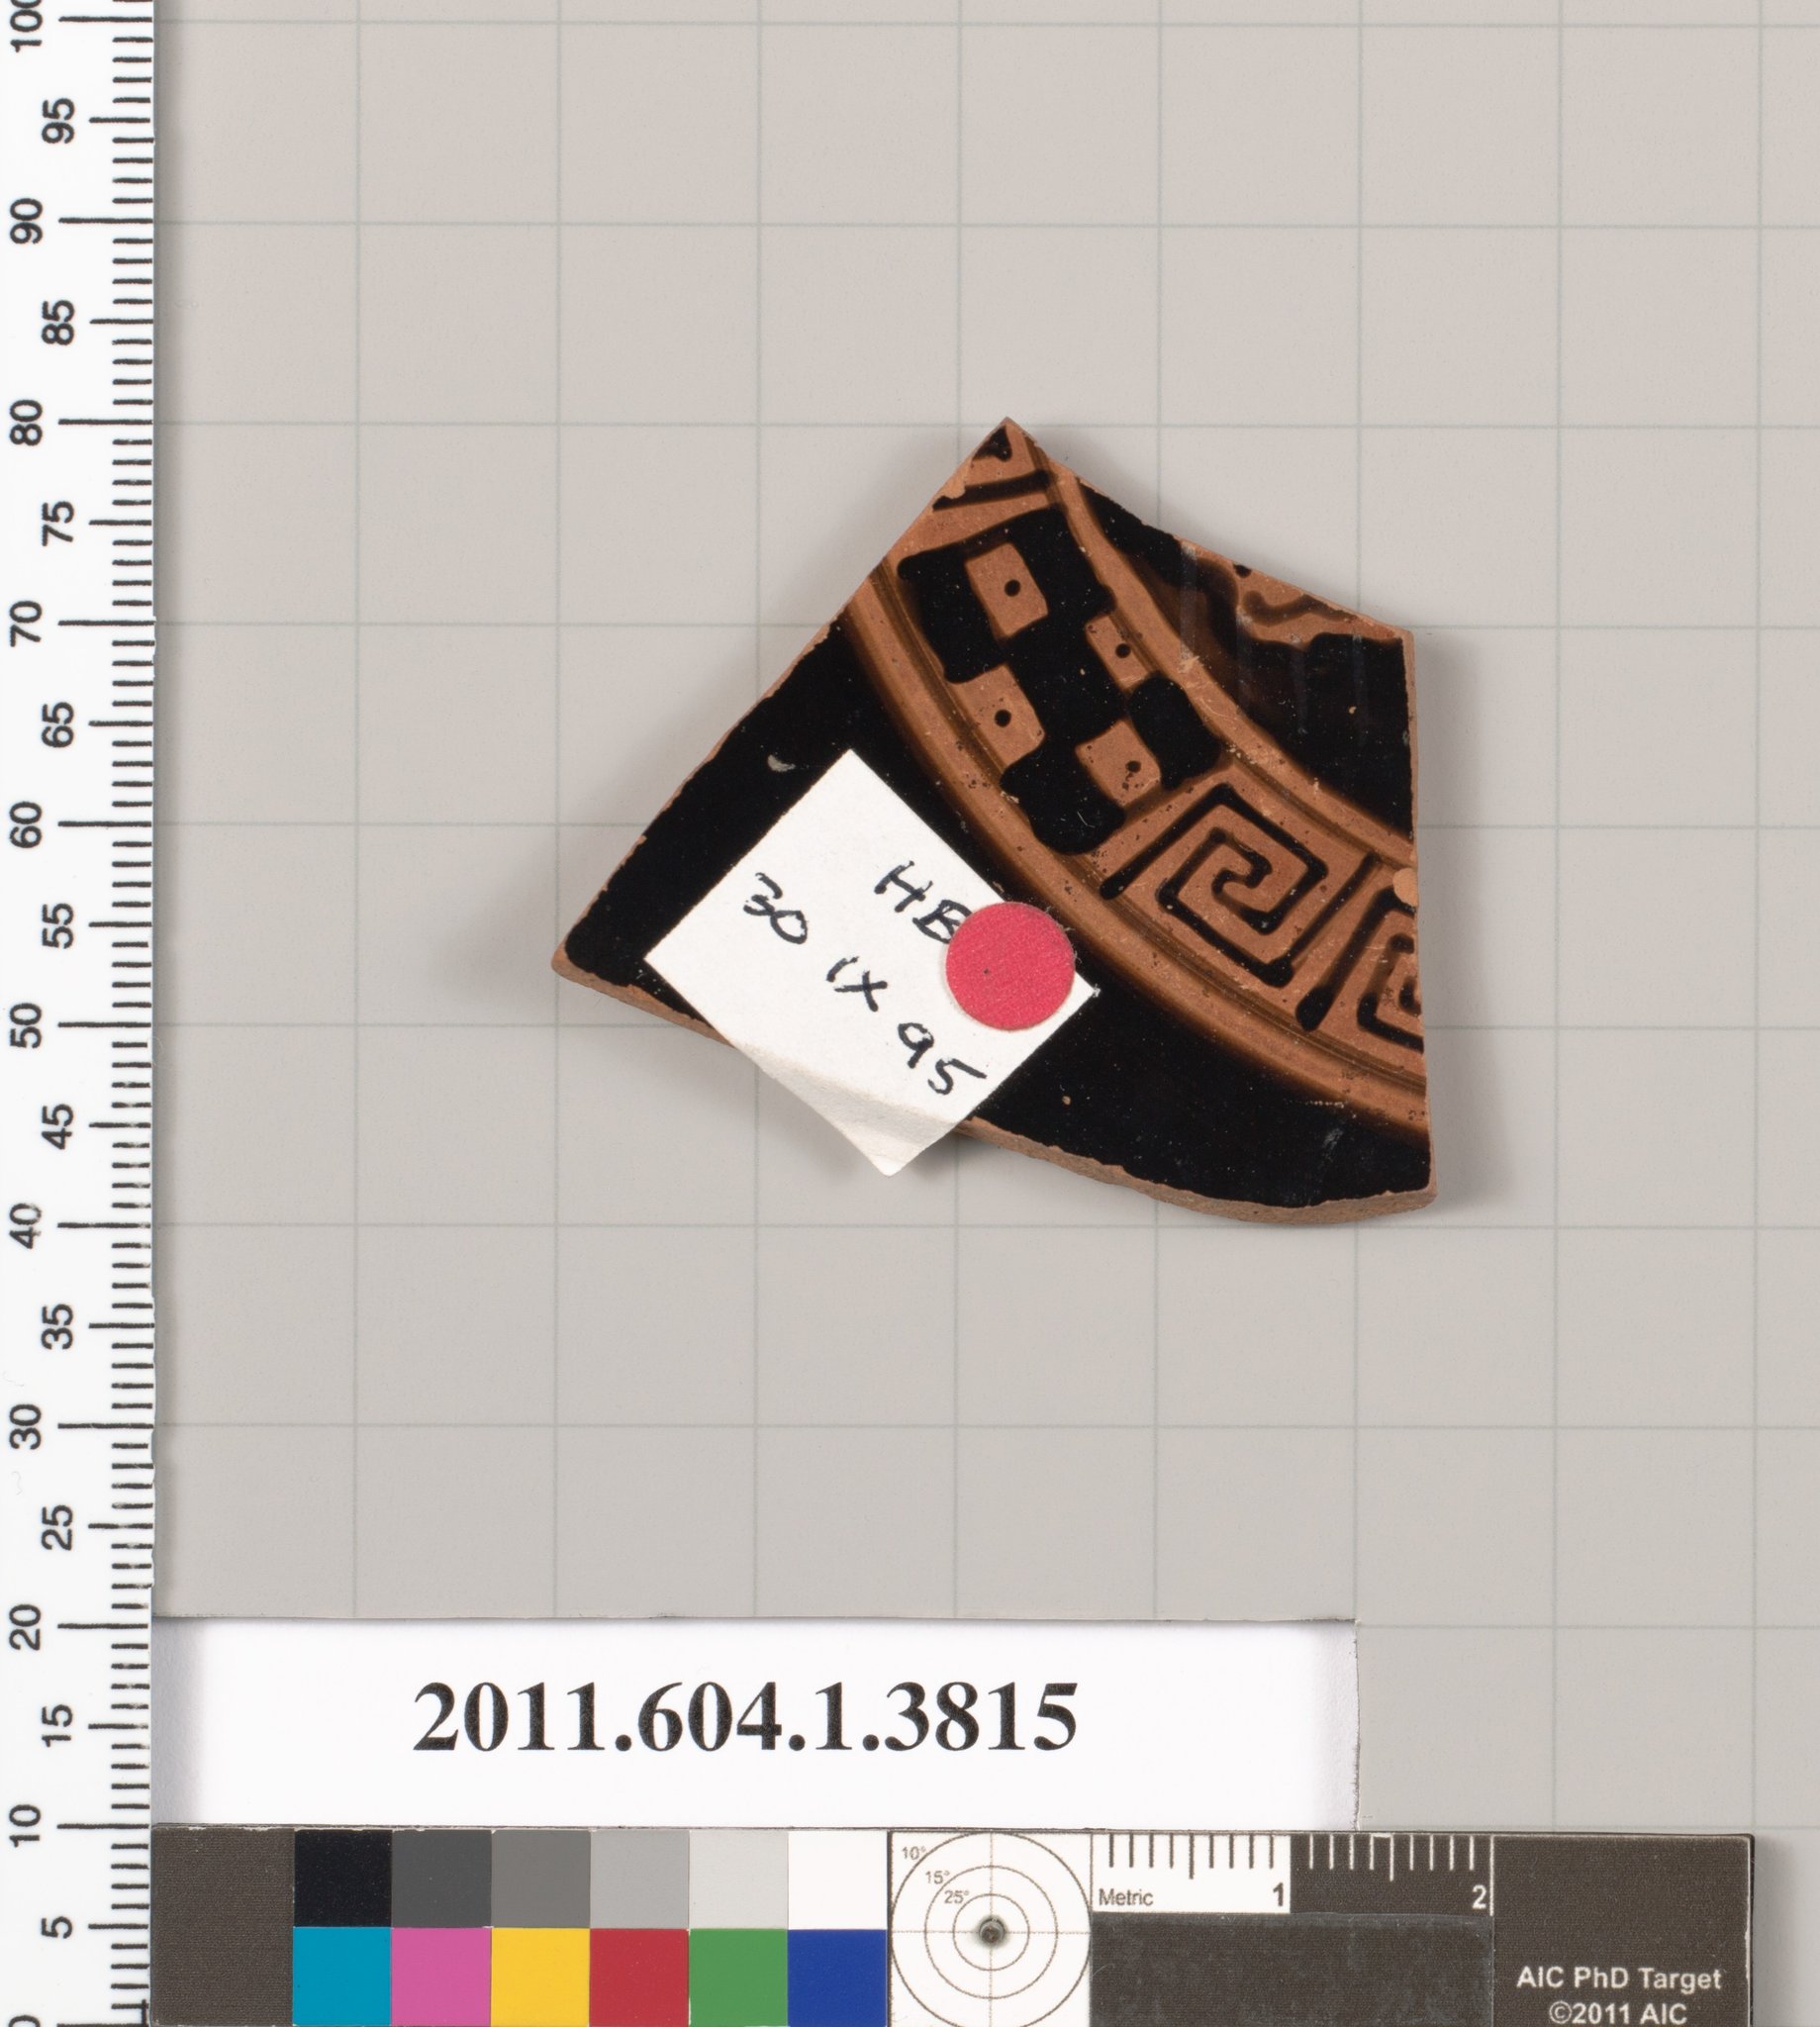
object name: kylix fragment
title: Terracotta fragment of a kylix (drinking cup)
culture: greek, attic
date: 460-450 BCE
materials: terracotta